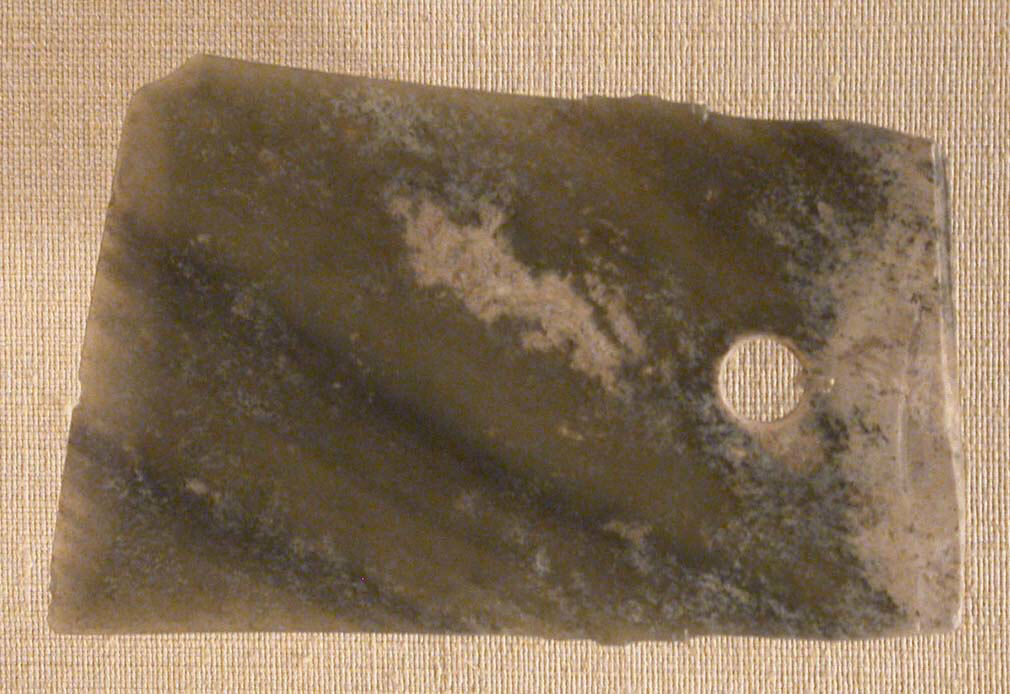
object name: ritual axe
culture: chinese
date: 3000-2001 BCE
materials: jade